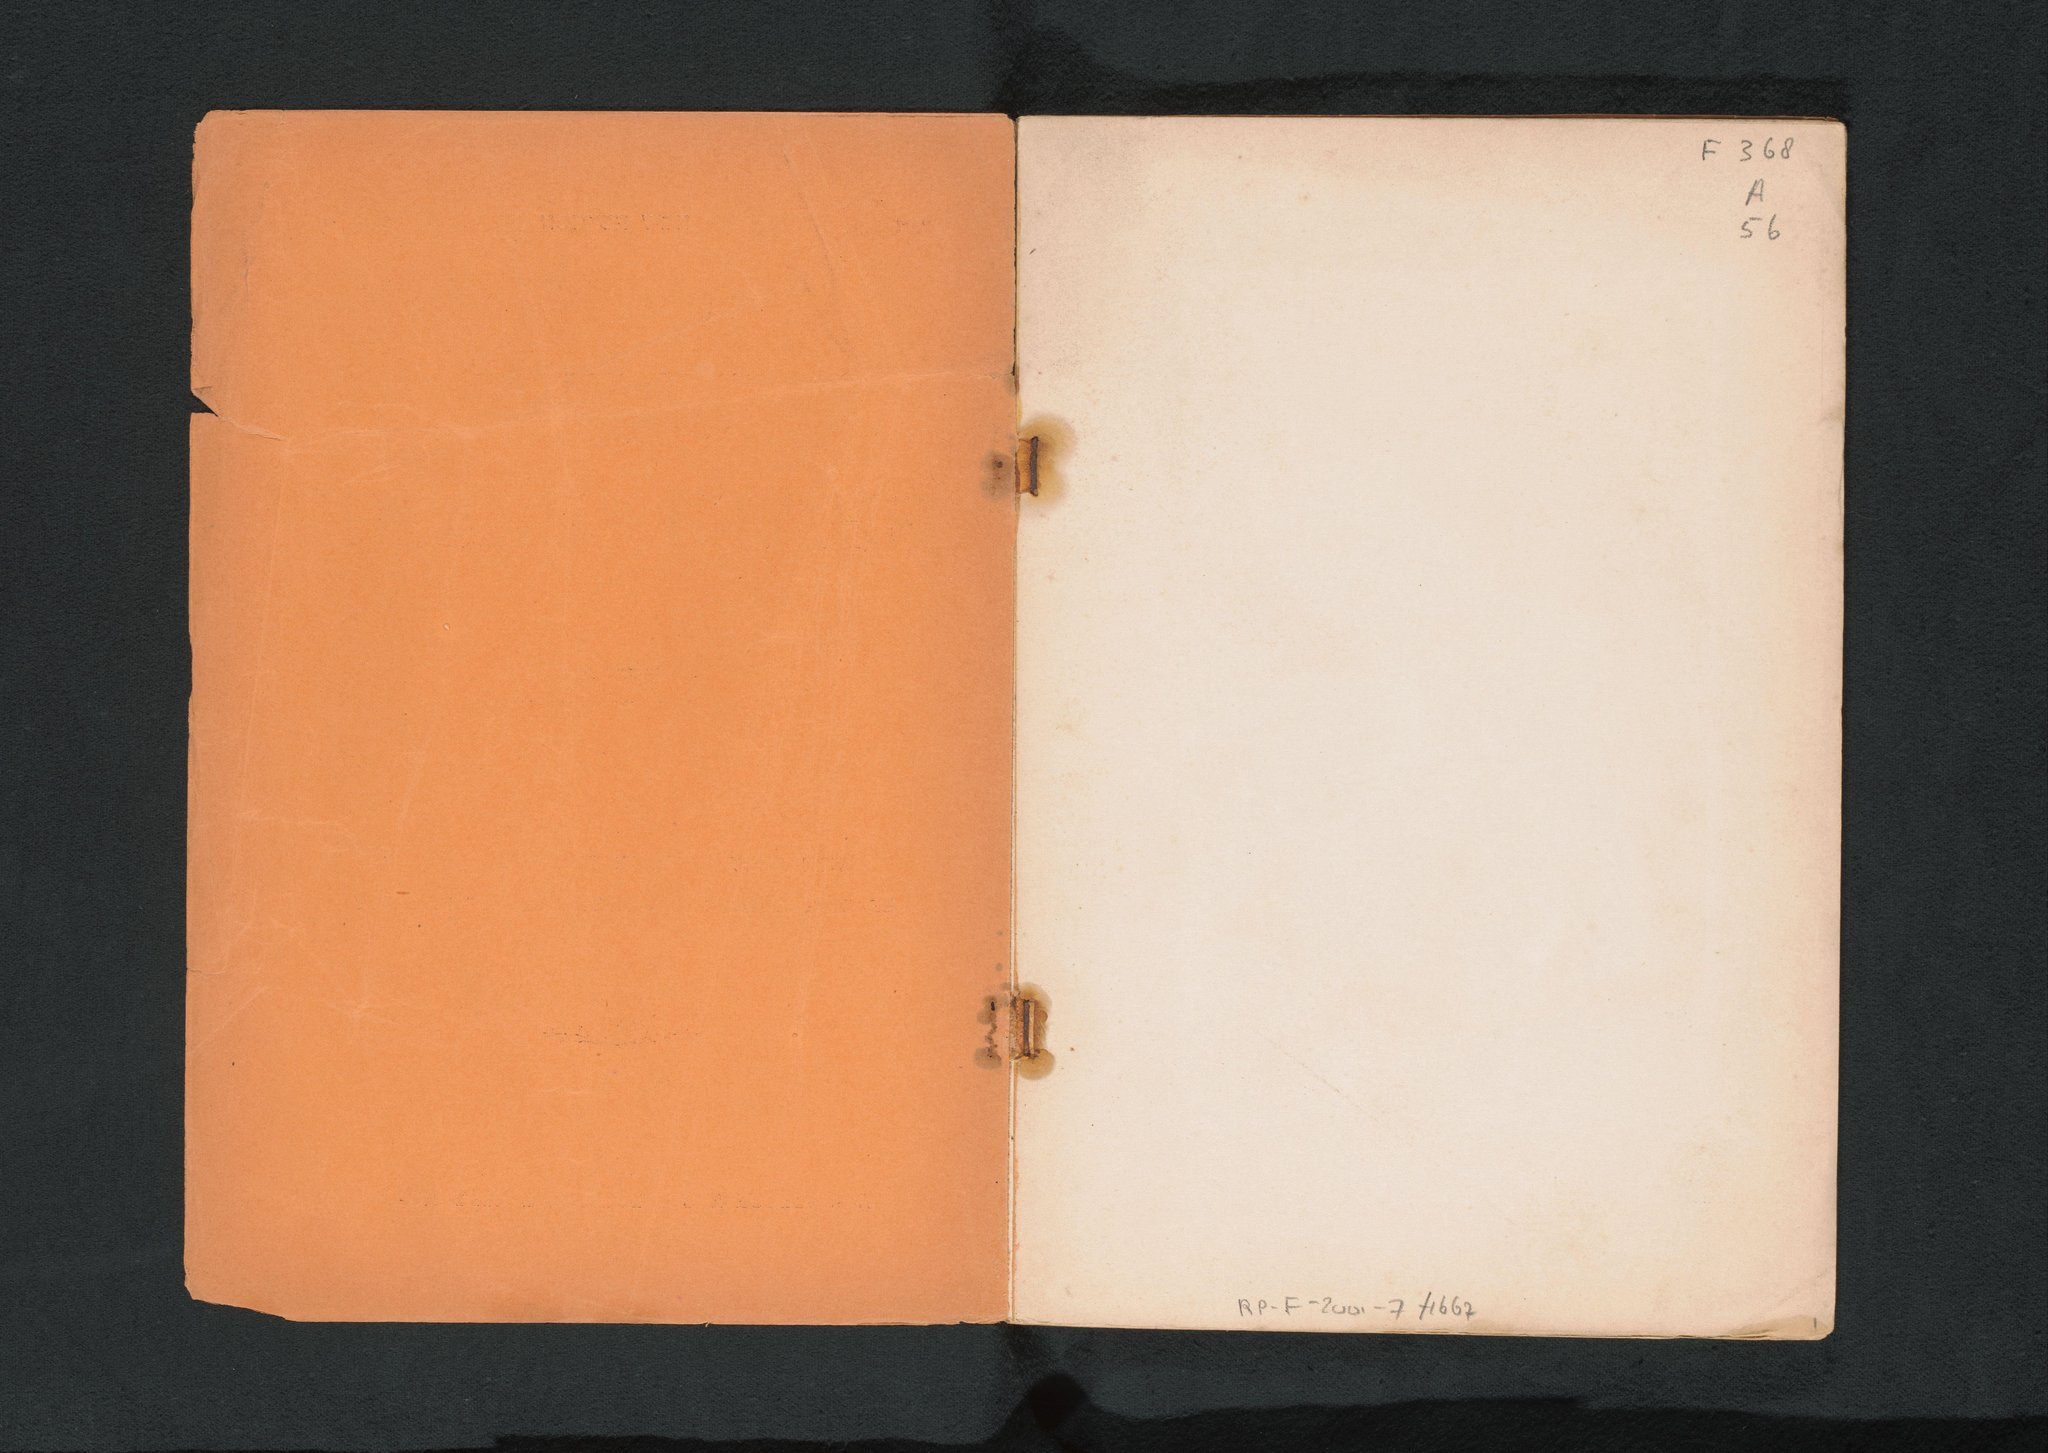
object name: book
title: The plays of Shakespeare / ed. by Thomas Keightley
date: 1890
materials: paper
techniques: photoaquatint, printing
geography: london